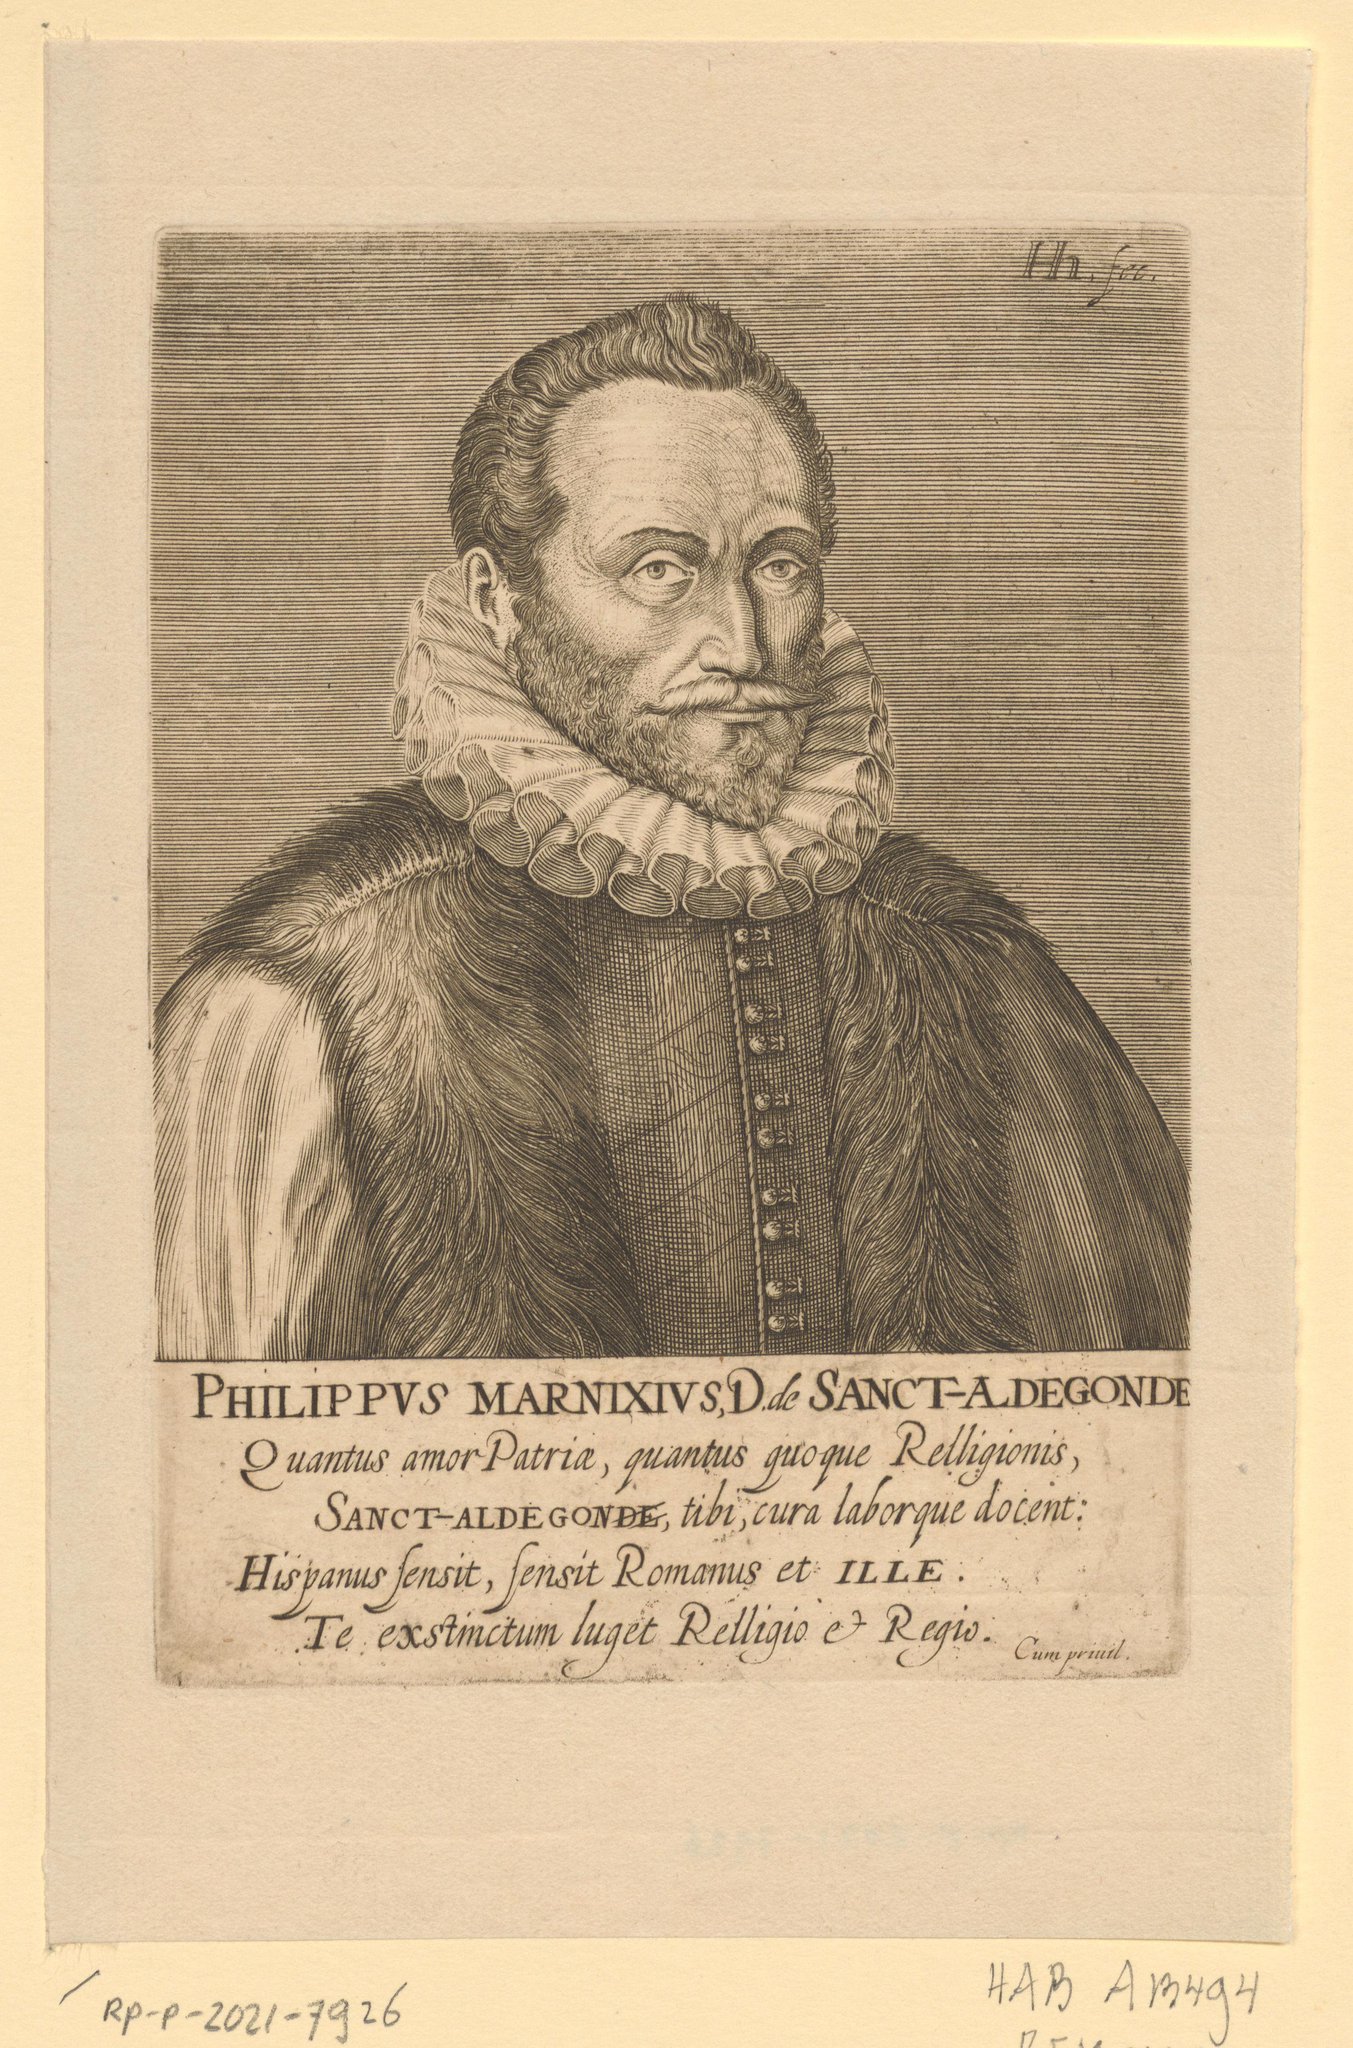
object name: print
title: Portret van Filips van Marnix van Sint-Aldegonde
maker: hendrick hondius (i)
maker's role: draughtsman, print maker, publisher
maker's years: 1573-1650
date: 1599-1604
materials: paper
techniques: engraving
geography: the hague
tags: brussels, leiden, politician, filips van marnix van sint-aldegonde, historical persons, portrait of a writer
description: Prent ook gebruikt in publicaties uit 1603 en 1604, zie New Hollstein. Met tekst in boekdruk op verso is de prent gebruikt in 'Praestantium aliquot theologorum', 1602.